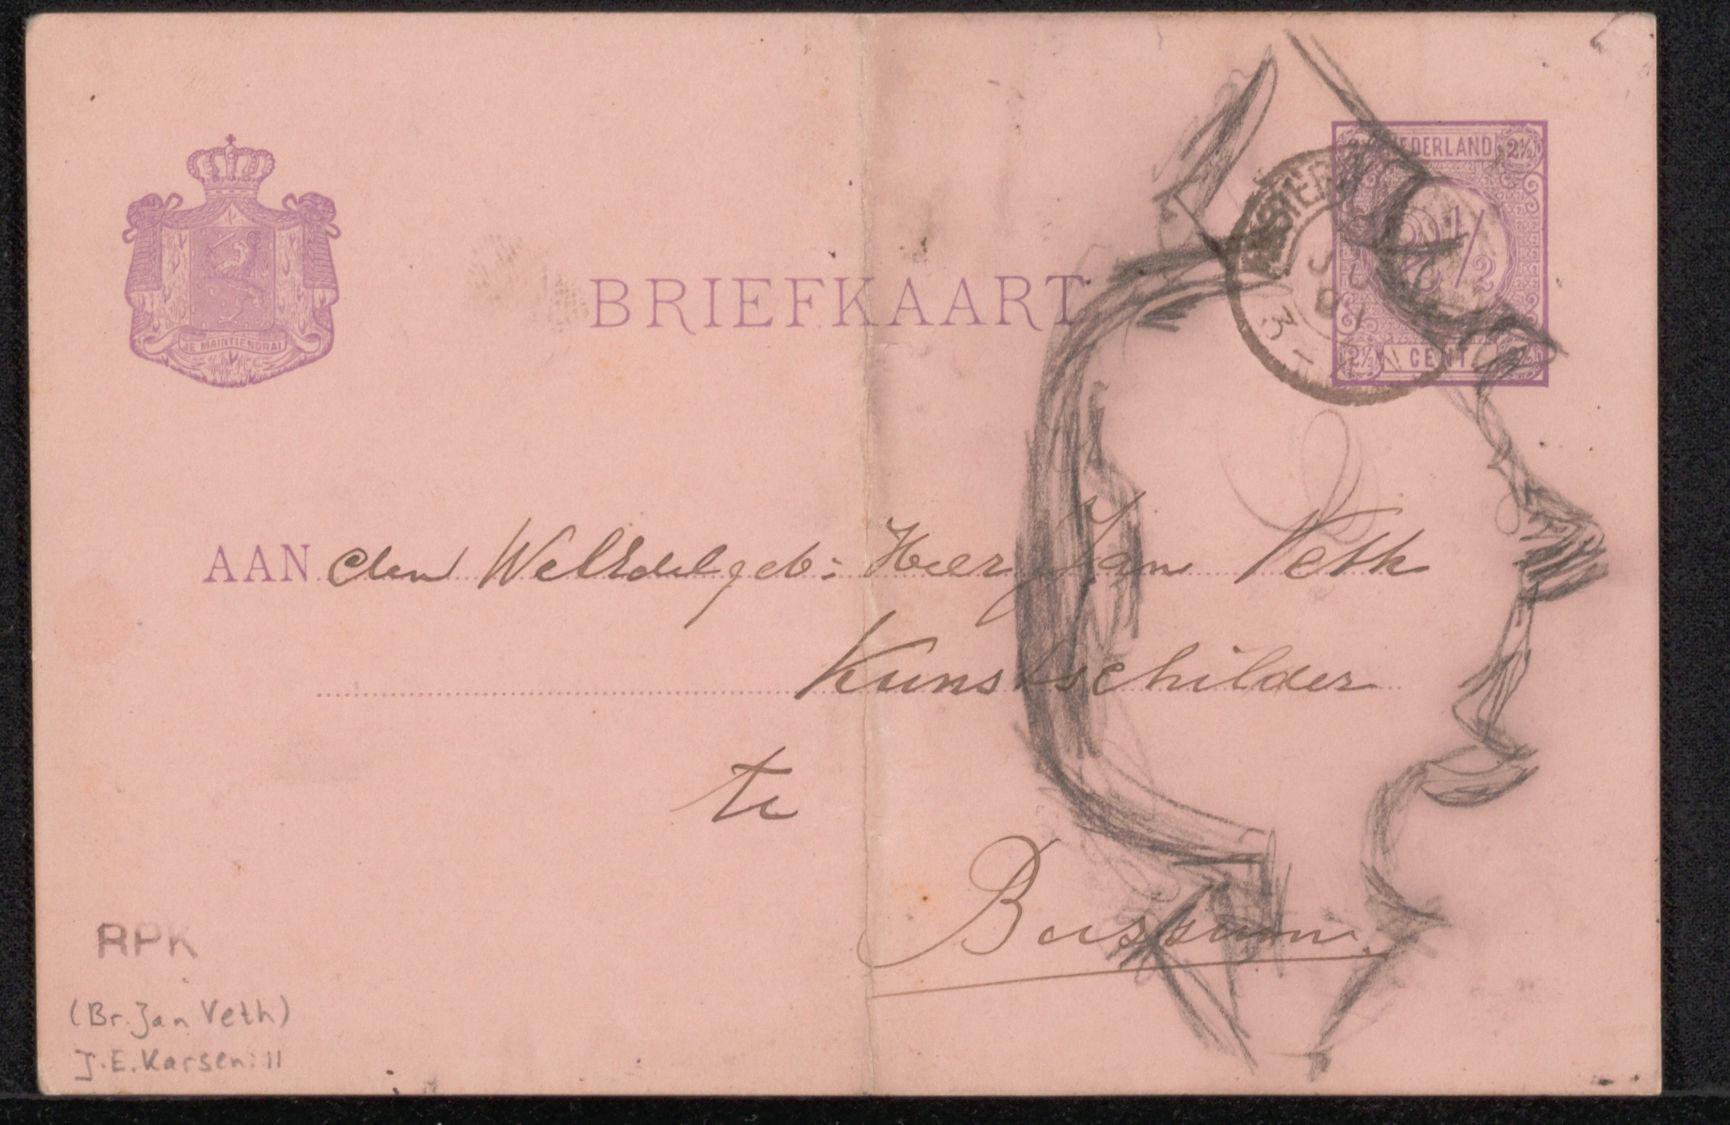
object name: postcard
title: Briefkaart aan Jan Veth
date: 1891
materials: cardboard, ink, pencil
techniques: pen, writing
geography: amsterdam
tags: dordrecht, jan veth, the graphic arts, painting (including book-illumination, miniature-painting), money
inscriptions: collector's mark: ‘RPK’